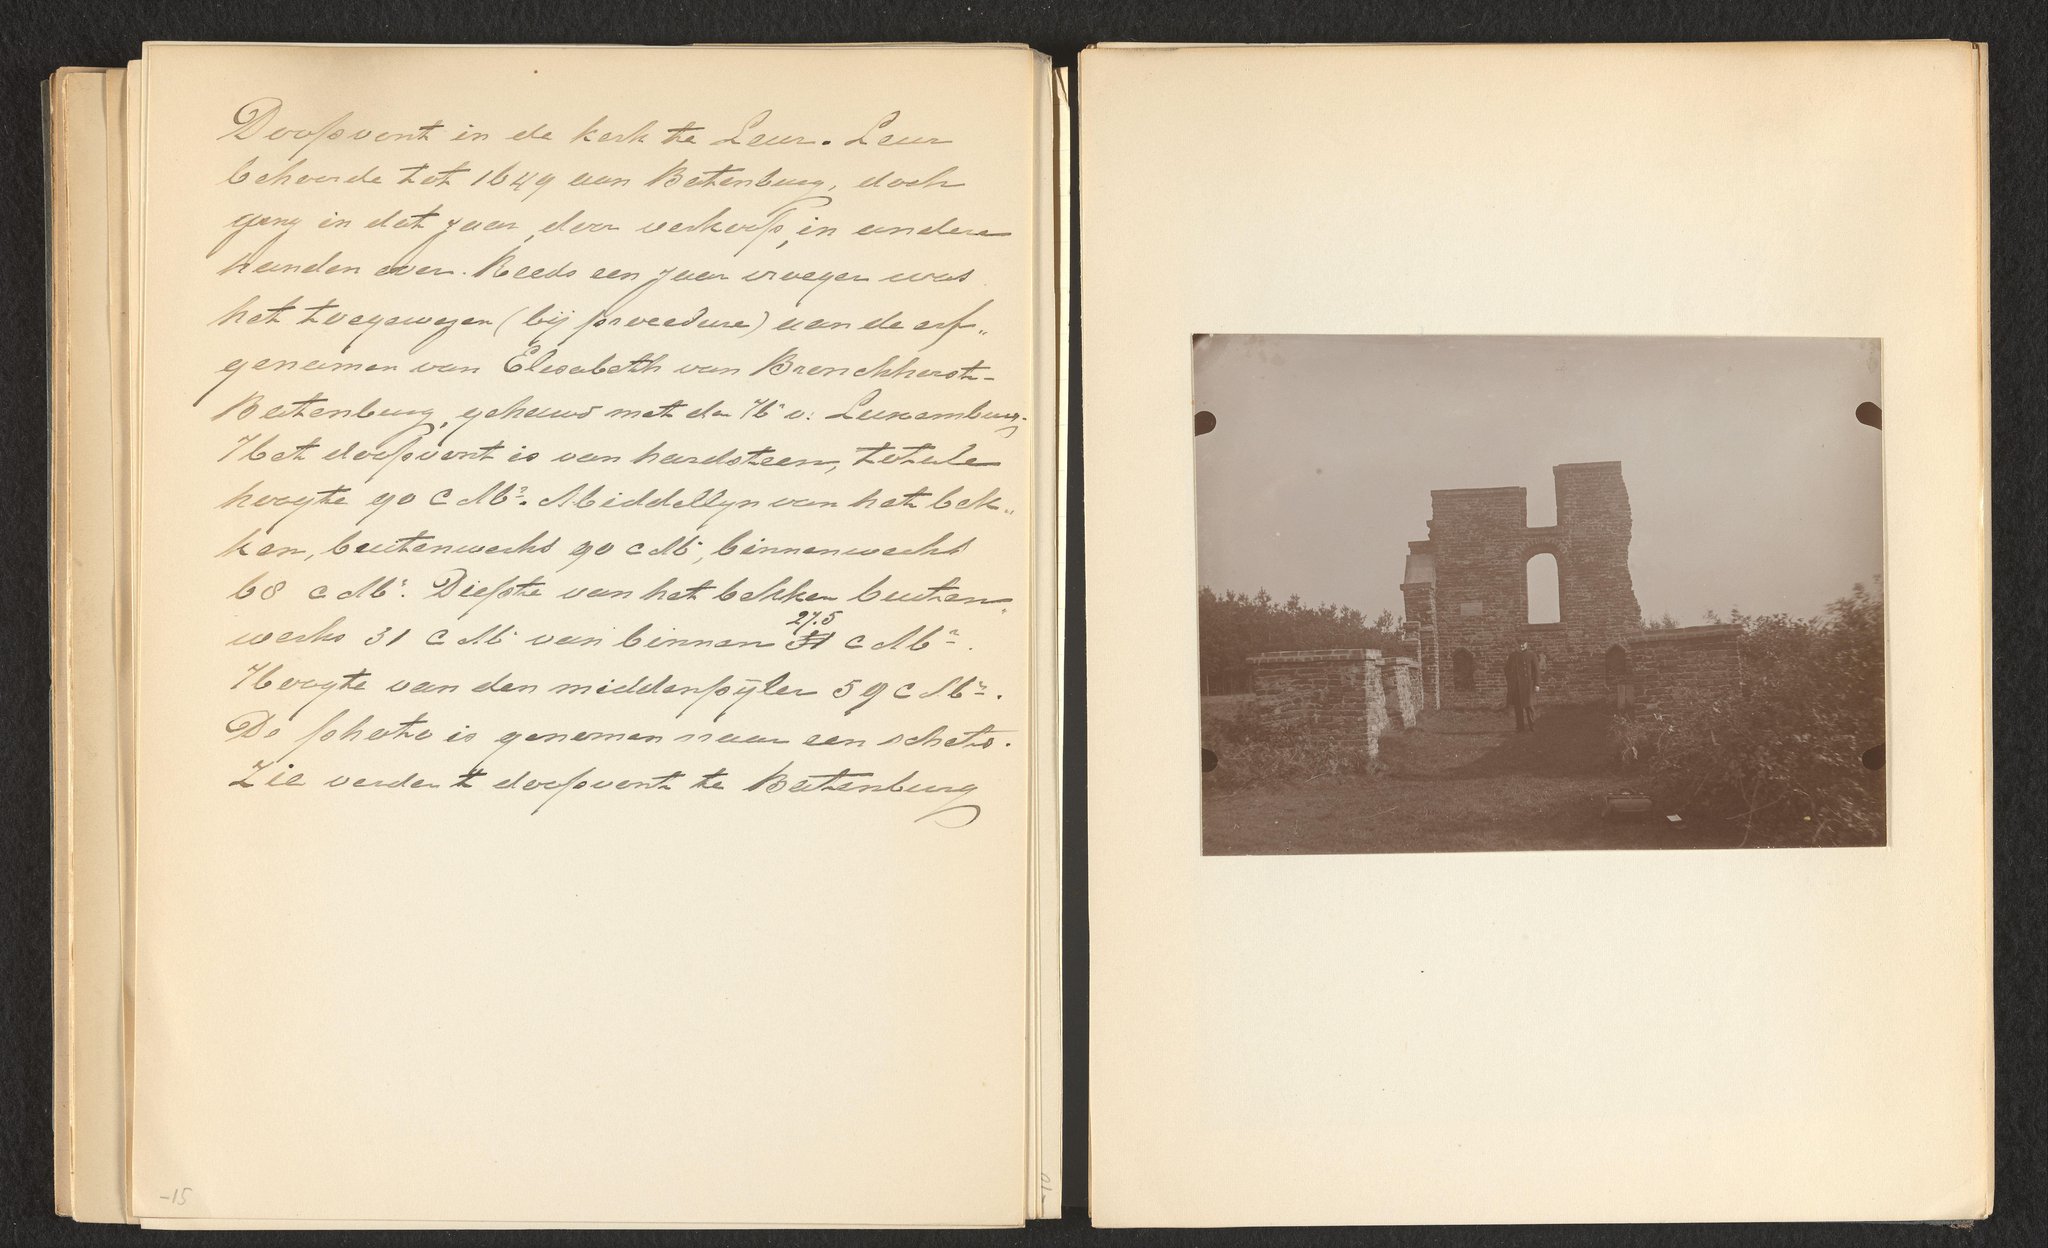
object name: photograph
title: Ruïne van de Sint-Walrickkapel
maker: benjamin charlé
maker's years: 1845-1925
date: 1909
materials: paper, cardboard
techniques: collodion silver print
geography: heumen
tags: ruin of church, monastery, etc.